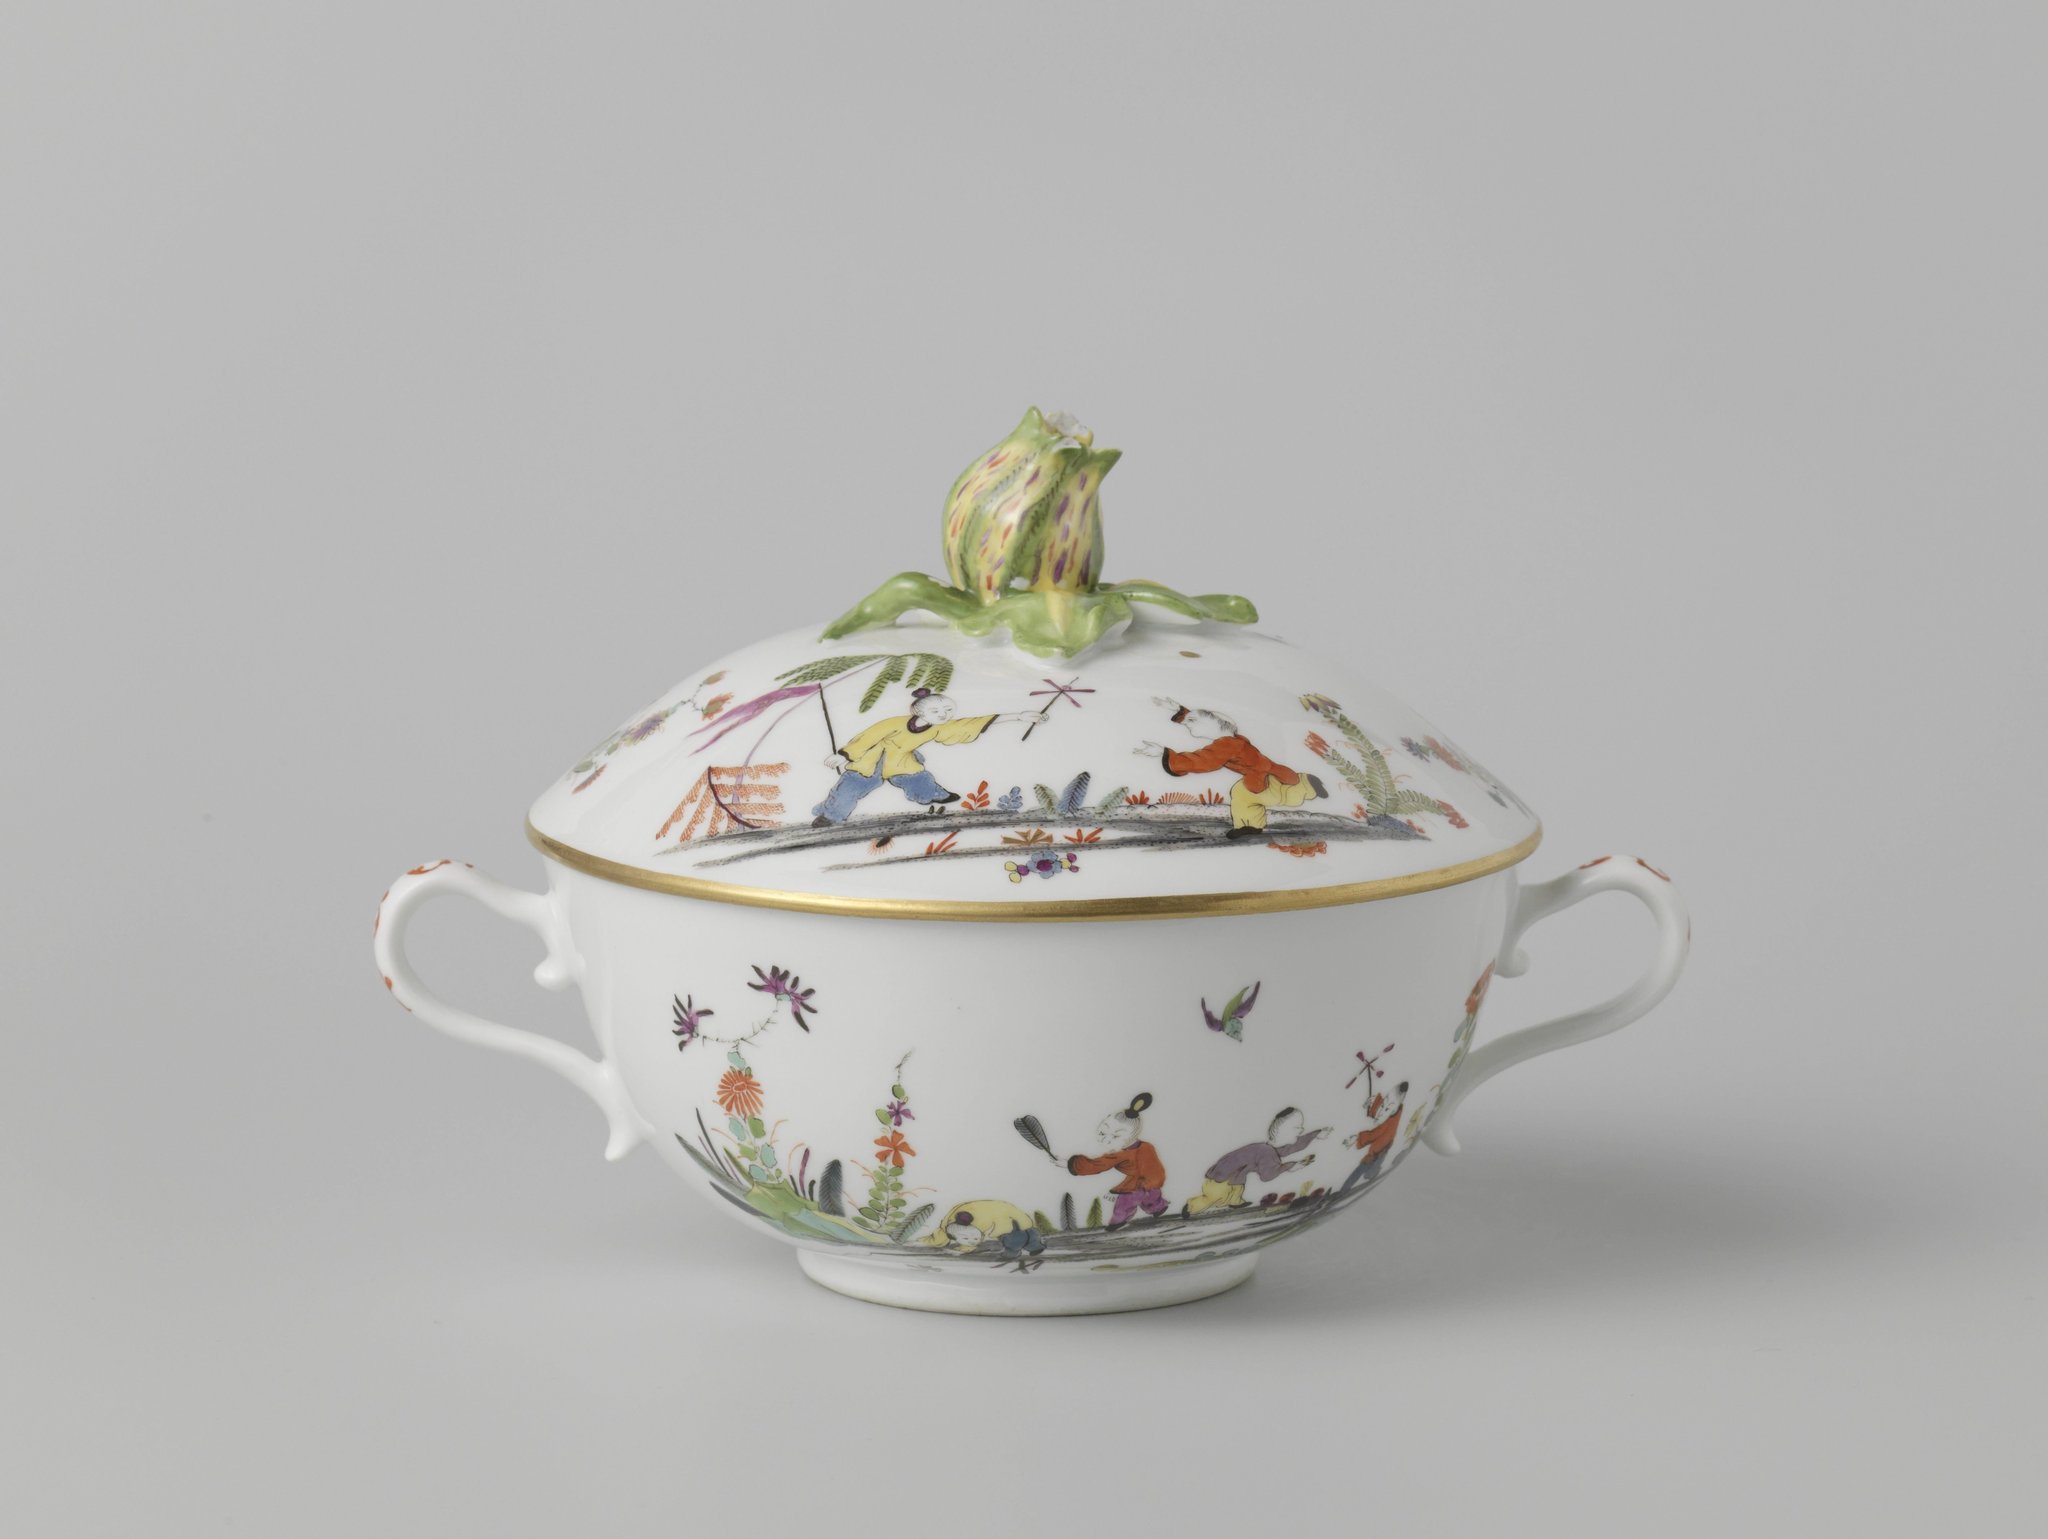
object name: eating drinking utensil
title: Deksel van terrine, veelkleurig beschilderd met chinoiserieën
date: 1730-1735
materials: porcelain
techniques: painted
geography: meissen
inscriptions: number: ‘325.’, factory mark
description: Deksel van beschilderd porselein. Het deksel een bloemknop met bladeren als knop.